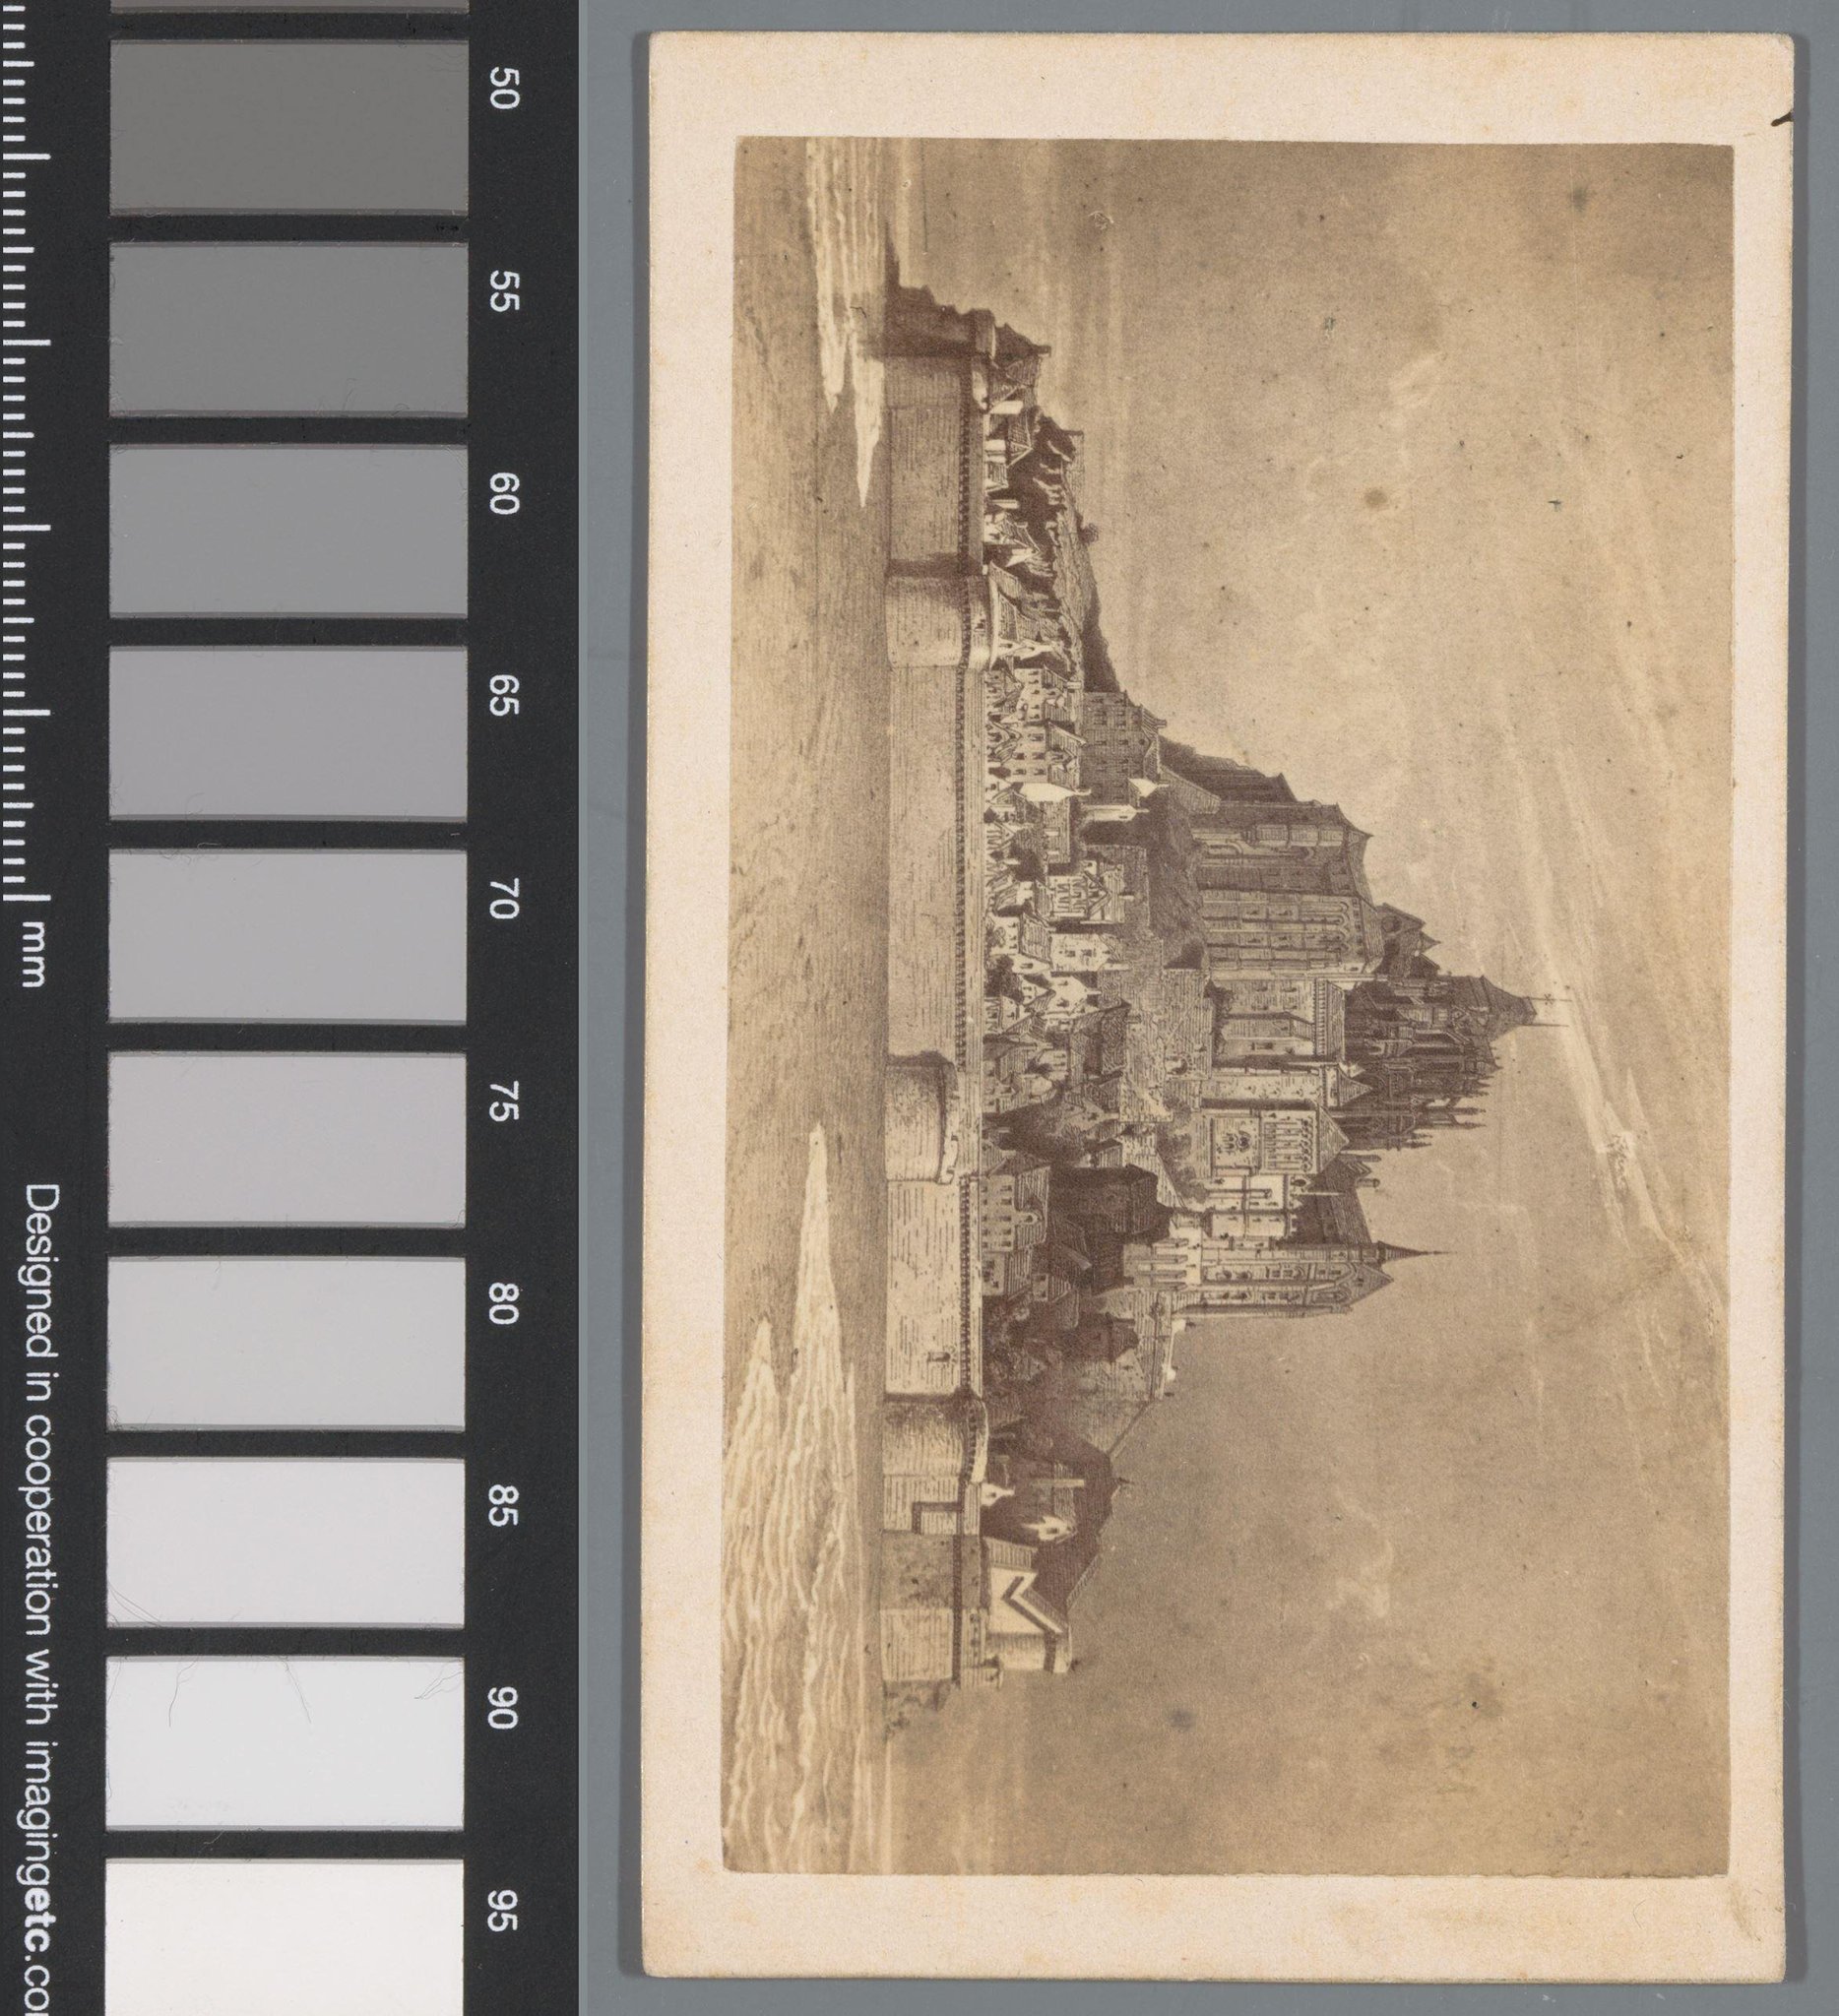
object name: reproduction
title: Fotoreproductie van een prent van Mont Saint-Michel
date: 1855-1885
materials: cardboard, paper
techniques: albumen print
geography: avranches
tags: island, abbey, monastery, convent ~ roman catholic church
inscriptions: inscription: ‘Aug.te Anfray/ Editeur/ des ouvrages et gravures/ Sur le Mont St. Michel et/ l'Avranchin./ (Avranches)’